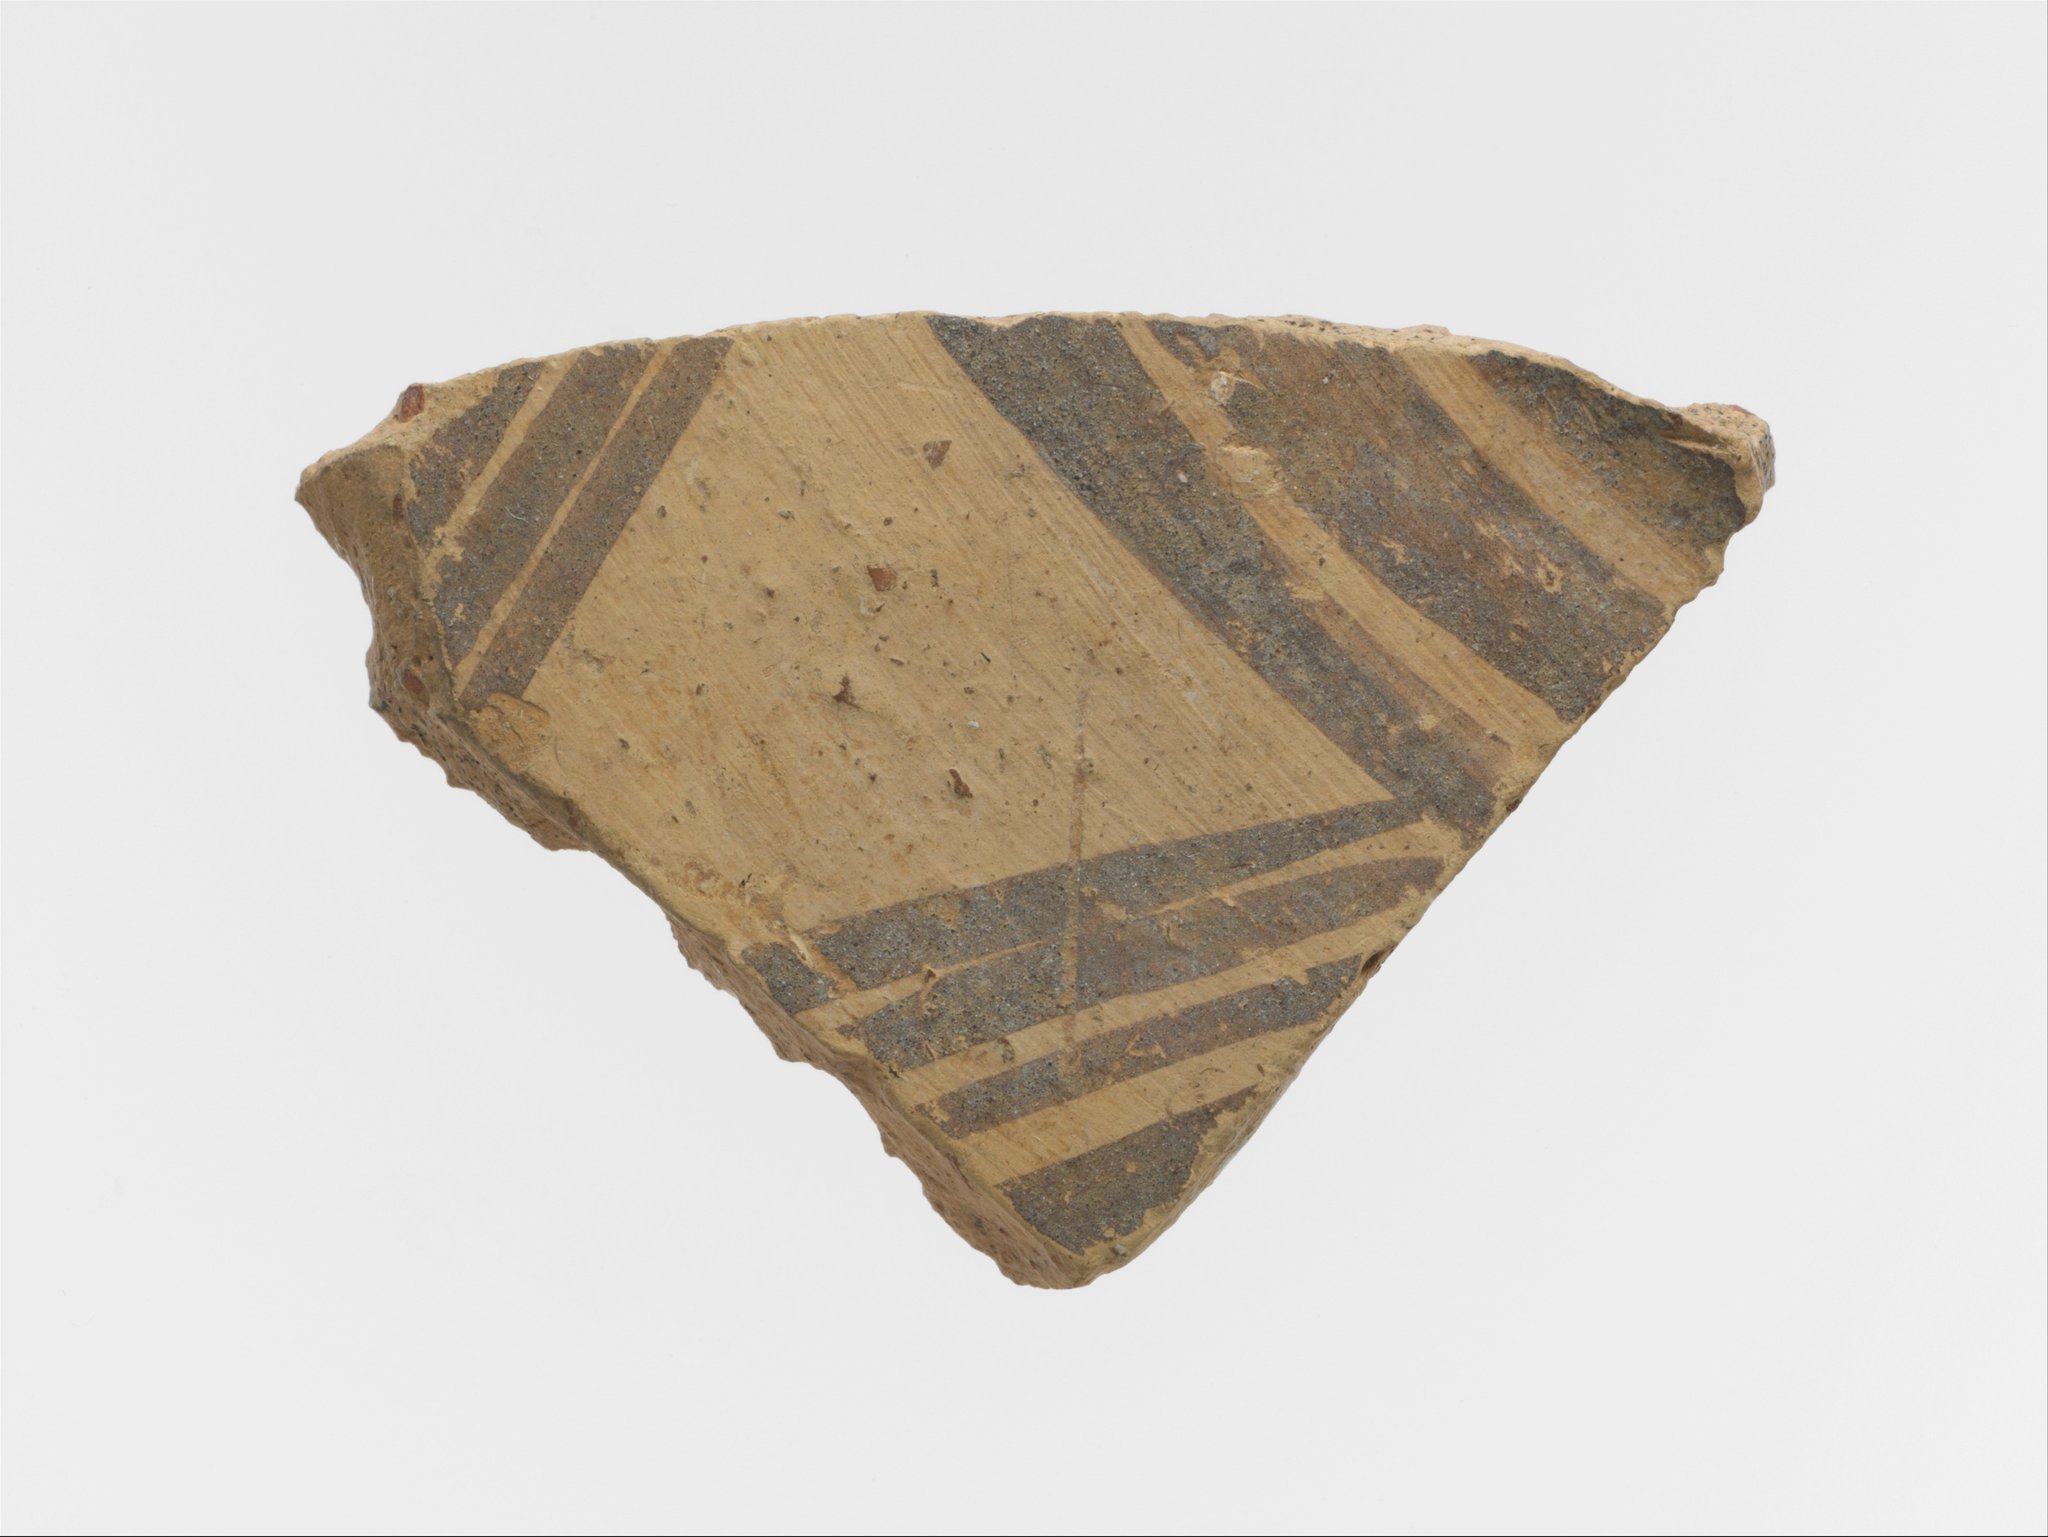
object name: vase fragment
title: Terracotta vessel fragment with linear decoration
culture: helladic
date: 2000-1550 BCE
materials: terracotta